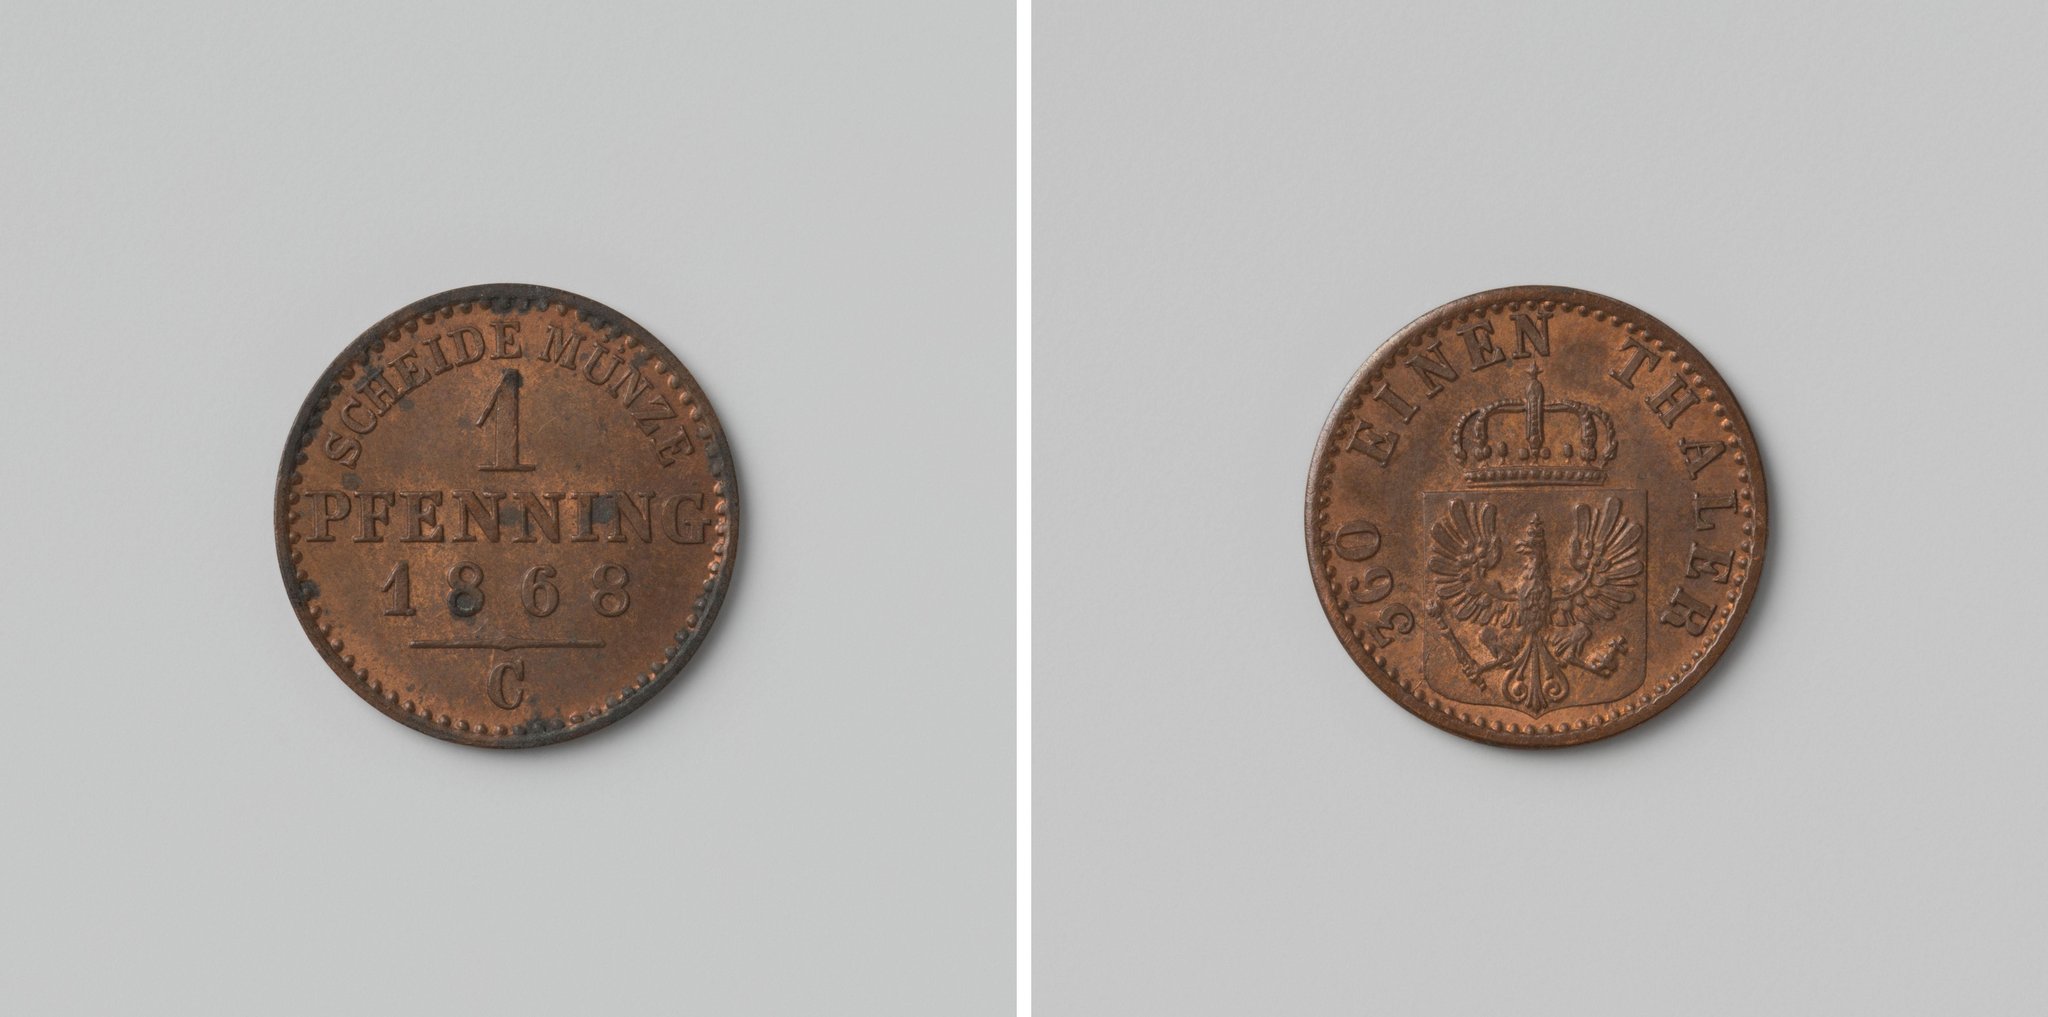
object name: coin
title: Pfennig van het koninkrijk Pruisen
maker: Anonymous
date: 1868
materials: copper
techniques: striking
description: Koperen munt. Voorzijde: opschrift binnen omschrift; afsnede: signatuur. Keerzijde: gekroond wapenschild binnen omschrift.